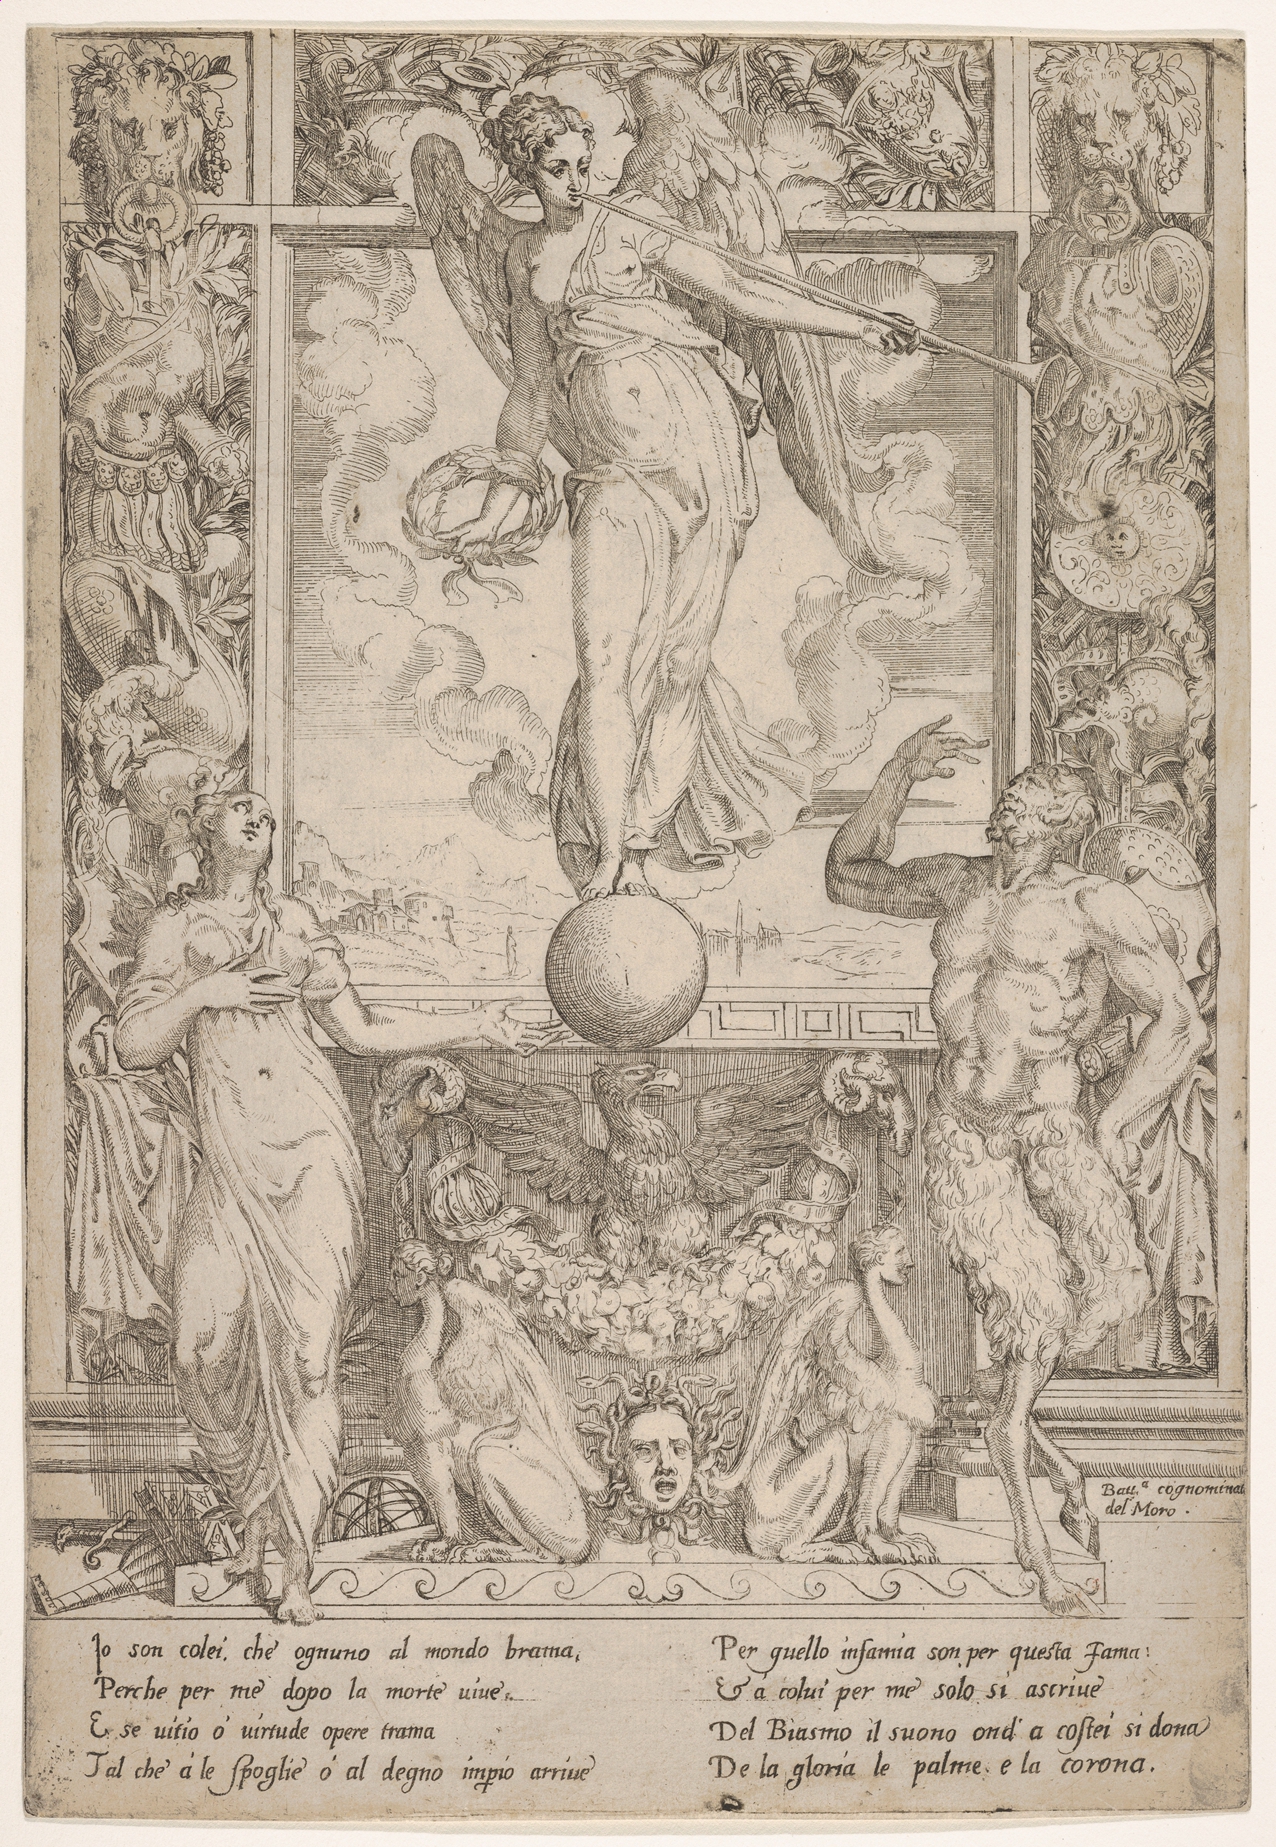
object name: print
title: Fame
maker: battista angolo del moro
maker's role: artist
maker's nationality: italian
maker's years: 1515-1573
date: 1515-1590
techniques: engraving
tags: musical instruments,women,lions,angels